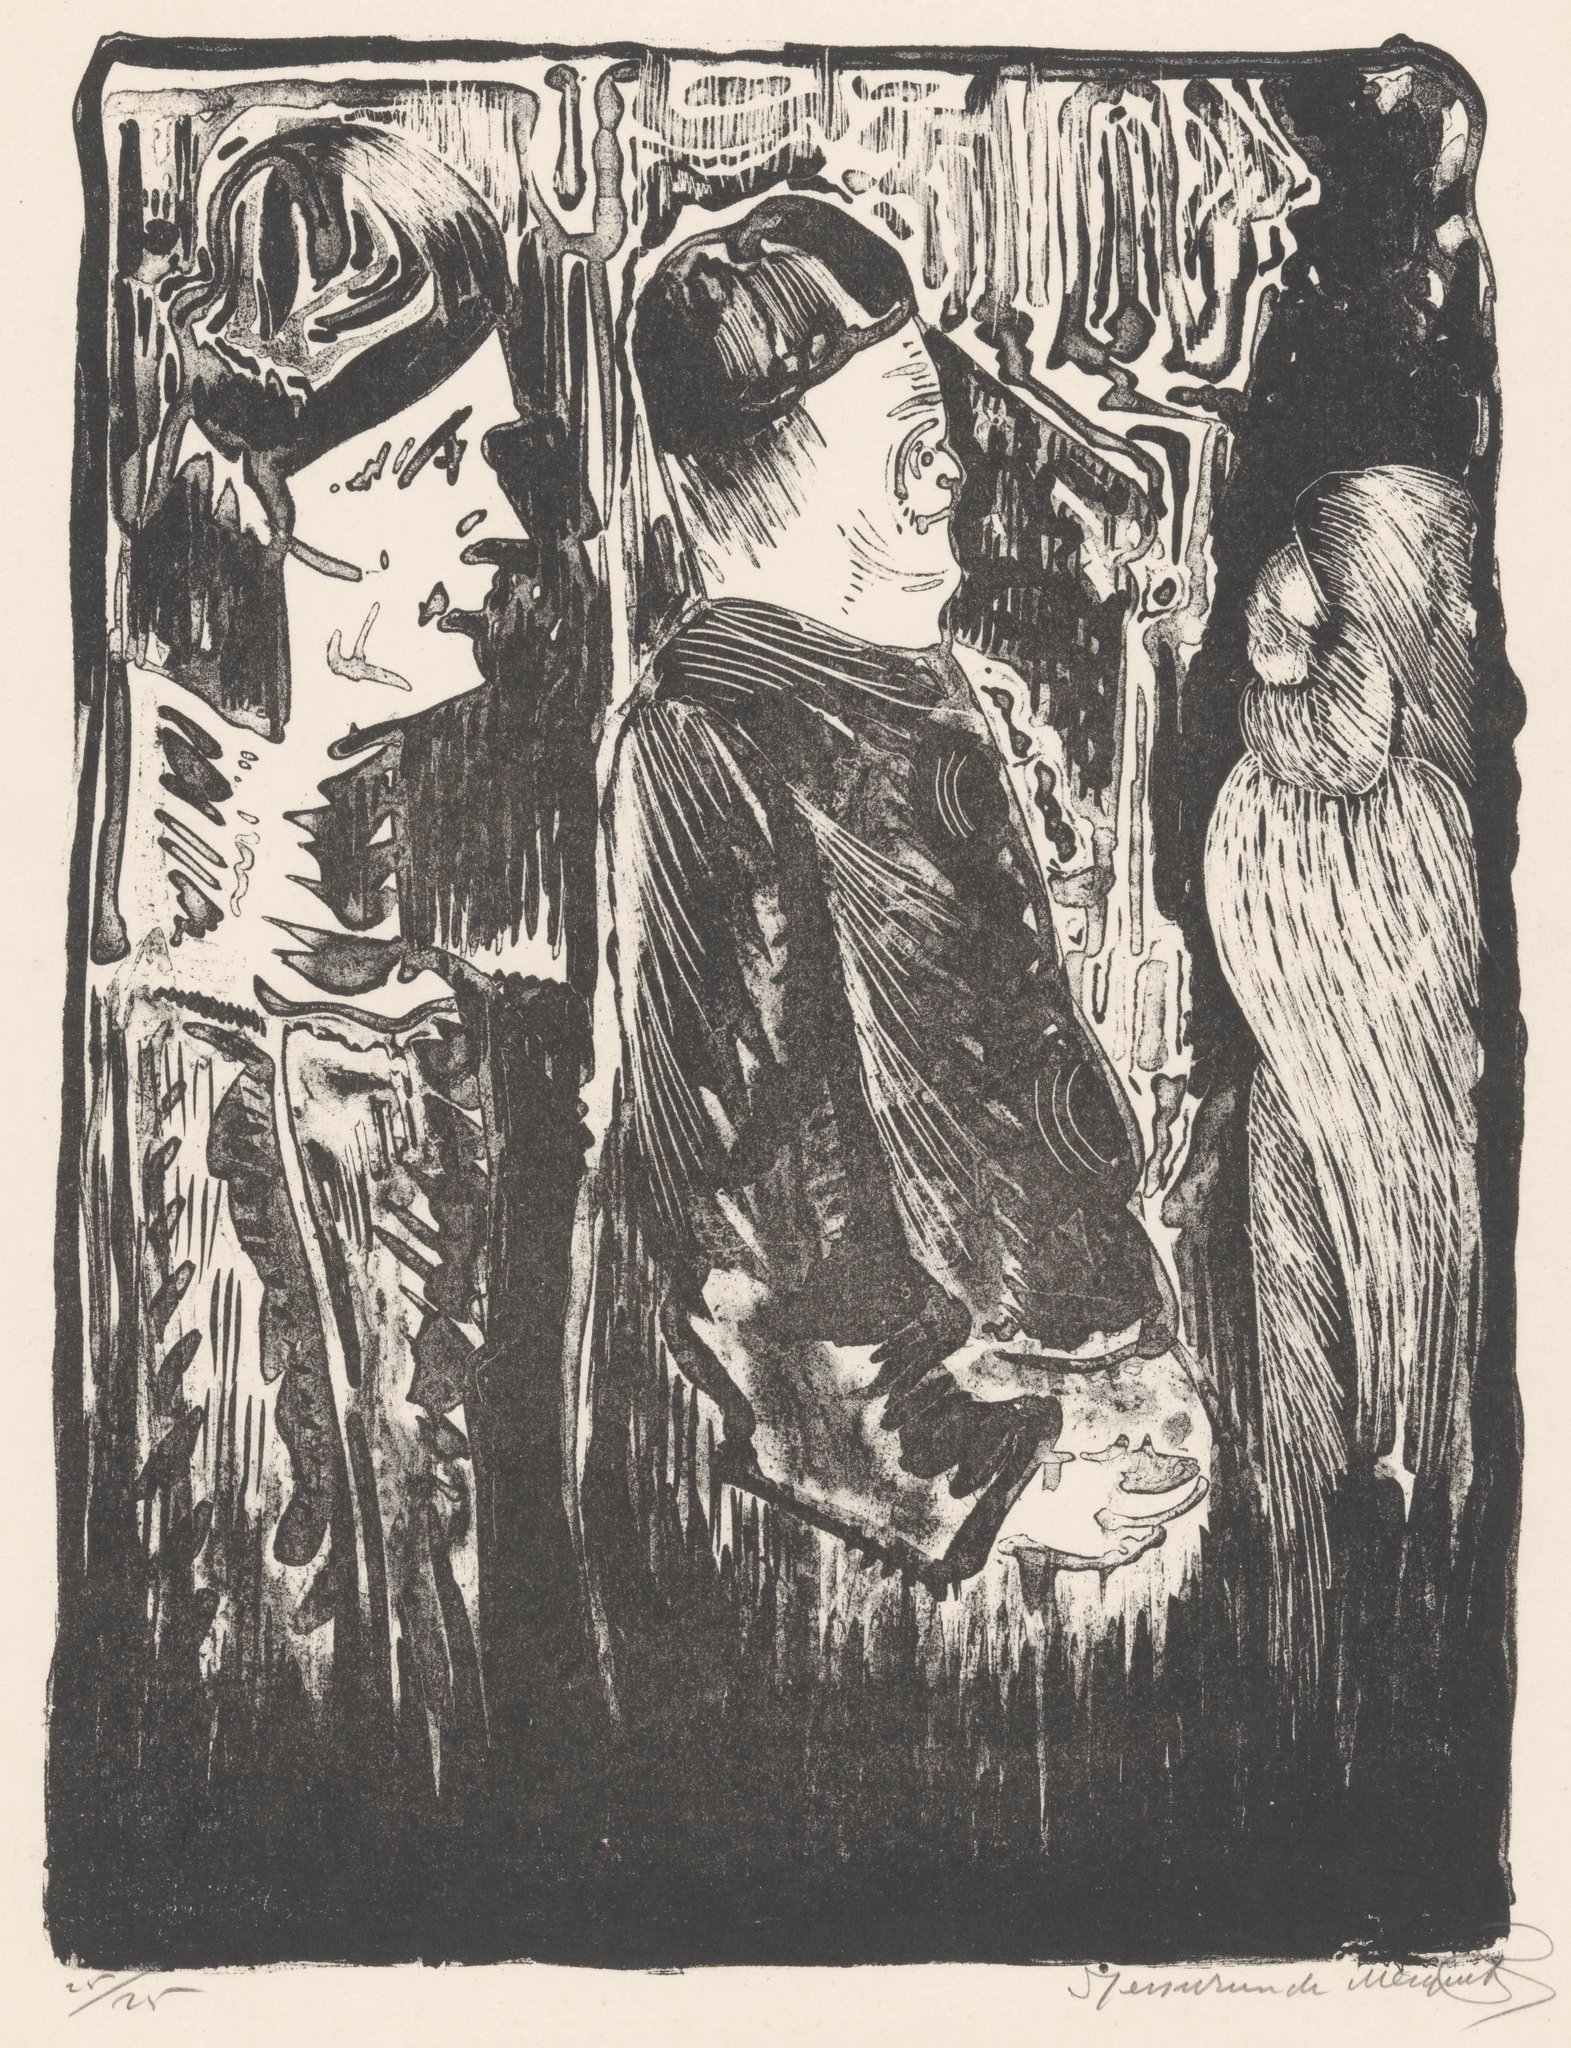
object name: print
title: Fantasie: links twee figuren met mutsen op naar rechts, rechts een ingekraste verschijning met verenkleed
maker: samuel jessurun de mesquita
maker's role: draughtsman, print maker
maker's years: 1868-1944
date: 1919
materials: paper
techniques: lithograph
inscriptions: signature: ‘Jessurun de Mesquita’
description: Links twee figuren met mutsen op naar rechts, rechts een ingekraste verschijning met verenkleed.